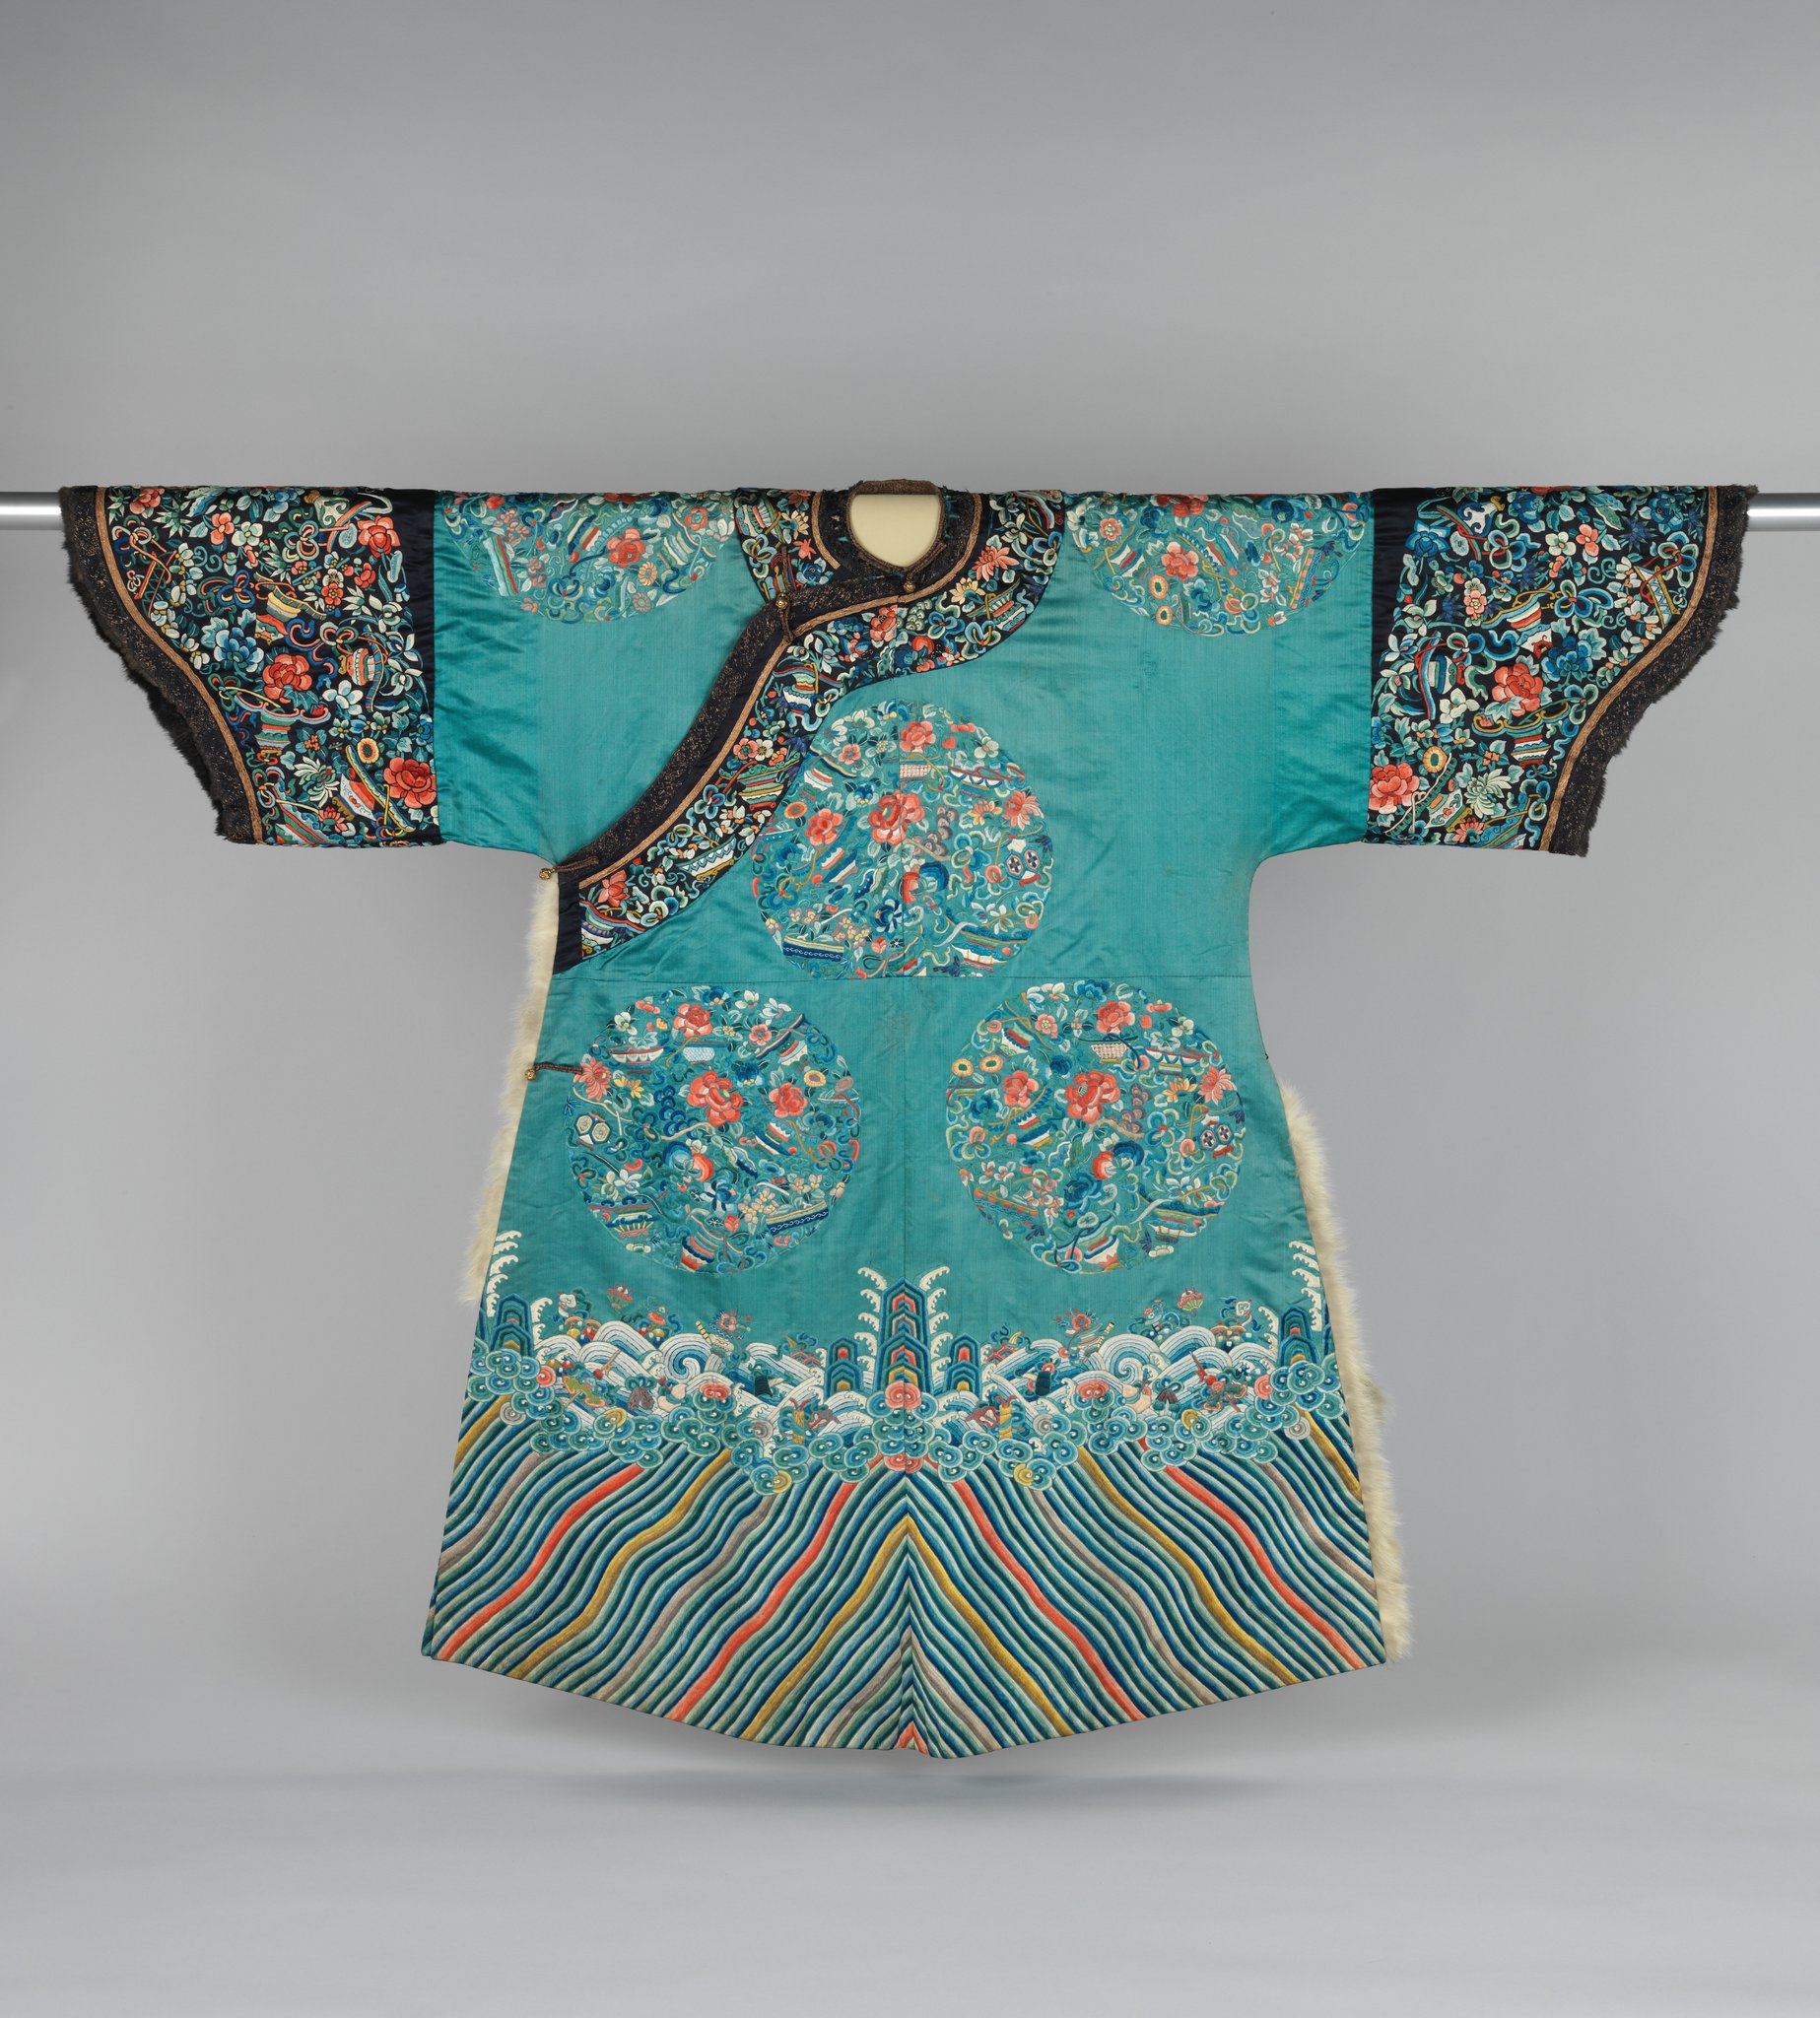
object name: woman's ceremonial robe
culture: chinese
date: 1801-1900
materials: fur, silk